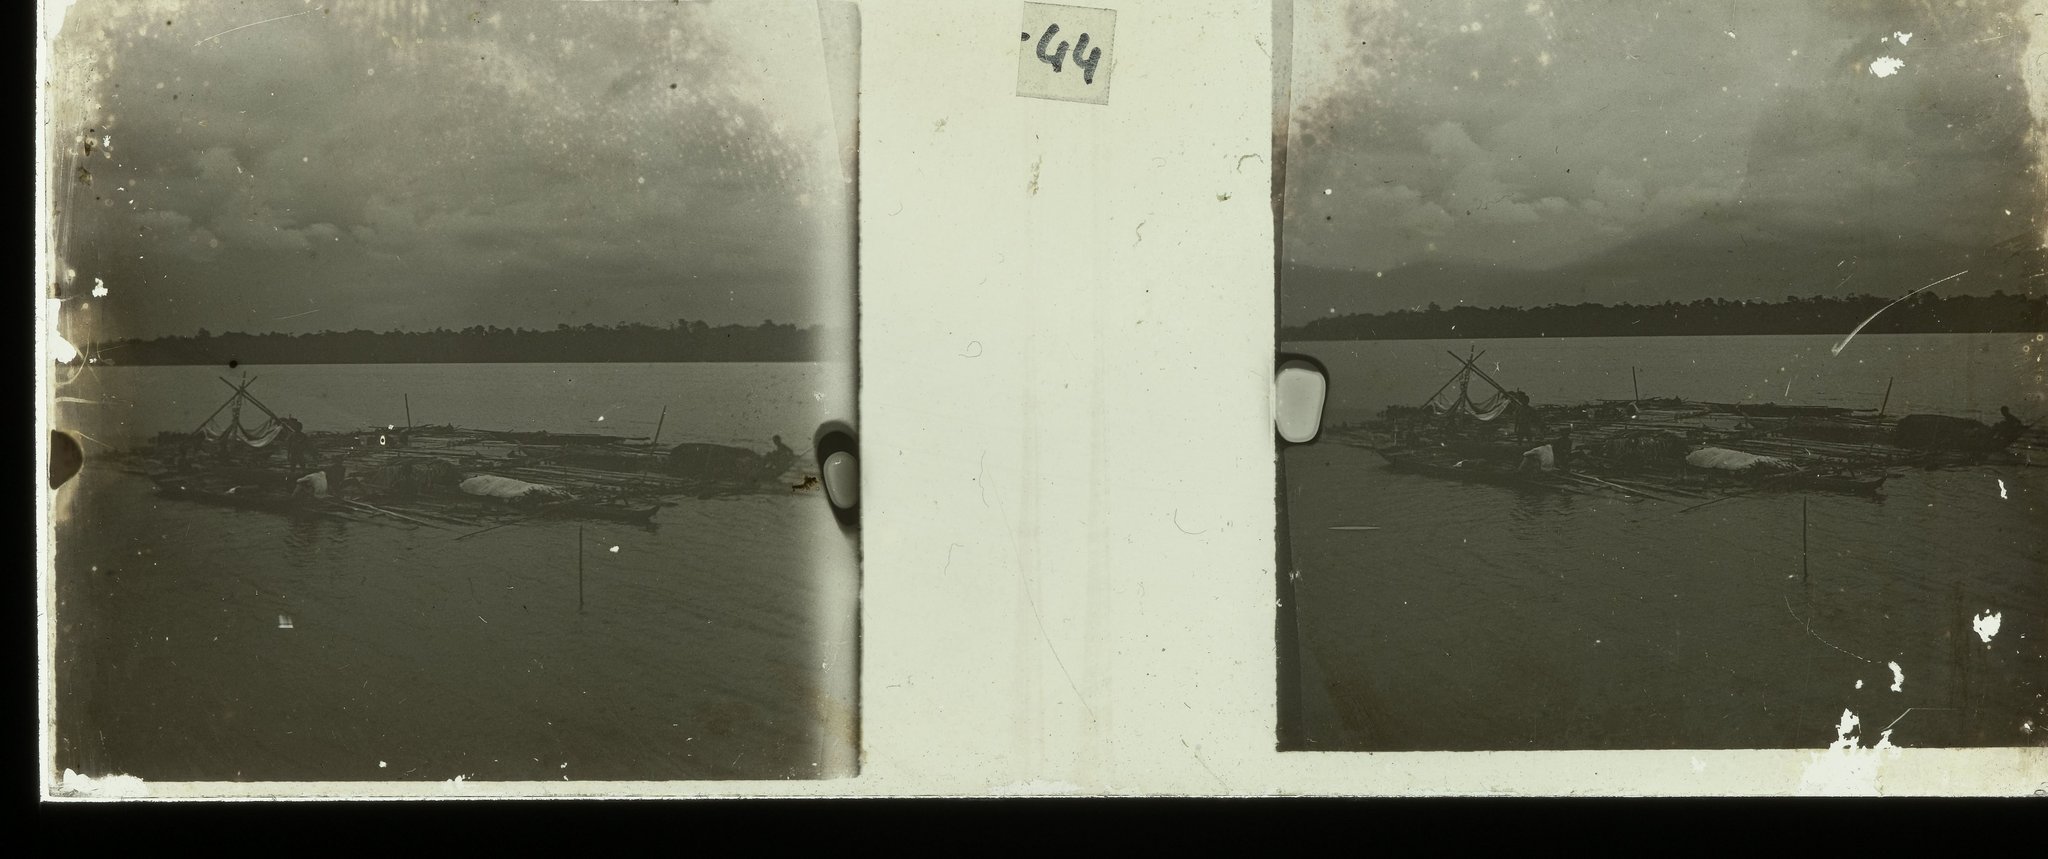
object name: stereograph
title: Houtvlot op de Surinamerivier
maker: theodoor brouwers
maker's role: amateurfotograaf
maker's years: 1874-1932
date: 1913-1930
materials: glass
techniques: photography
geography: suriname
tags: theodoor brouwers, suriname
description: In de periode 1911-1932 woonde op plantage Accaribo in Suriname de familie Brouwers van wie de foto's afkomstig zijn. Rond 1910 vond Theodoor Brouwers werk op plantage Accaribo. In 1929 werd hij eigenaar van de plantage. Op Accaribo werden in zijn tijd bananen geproduceerd en wat koffie.